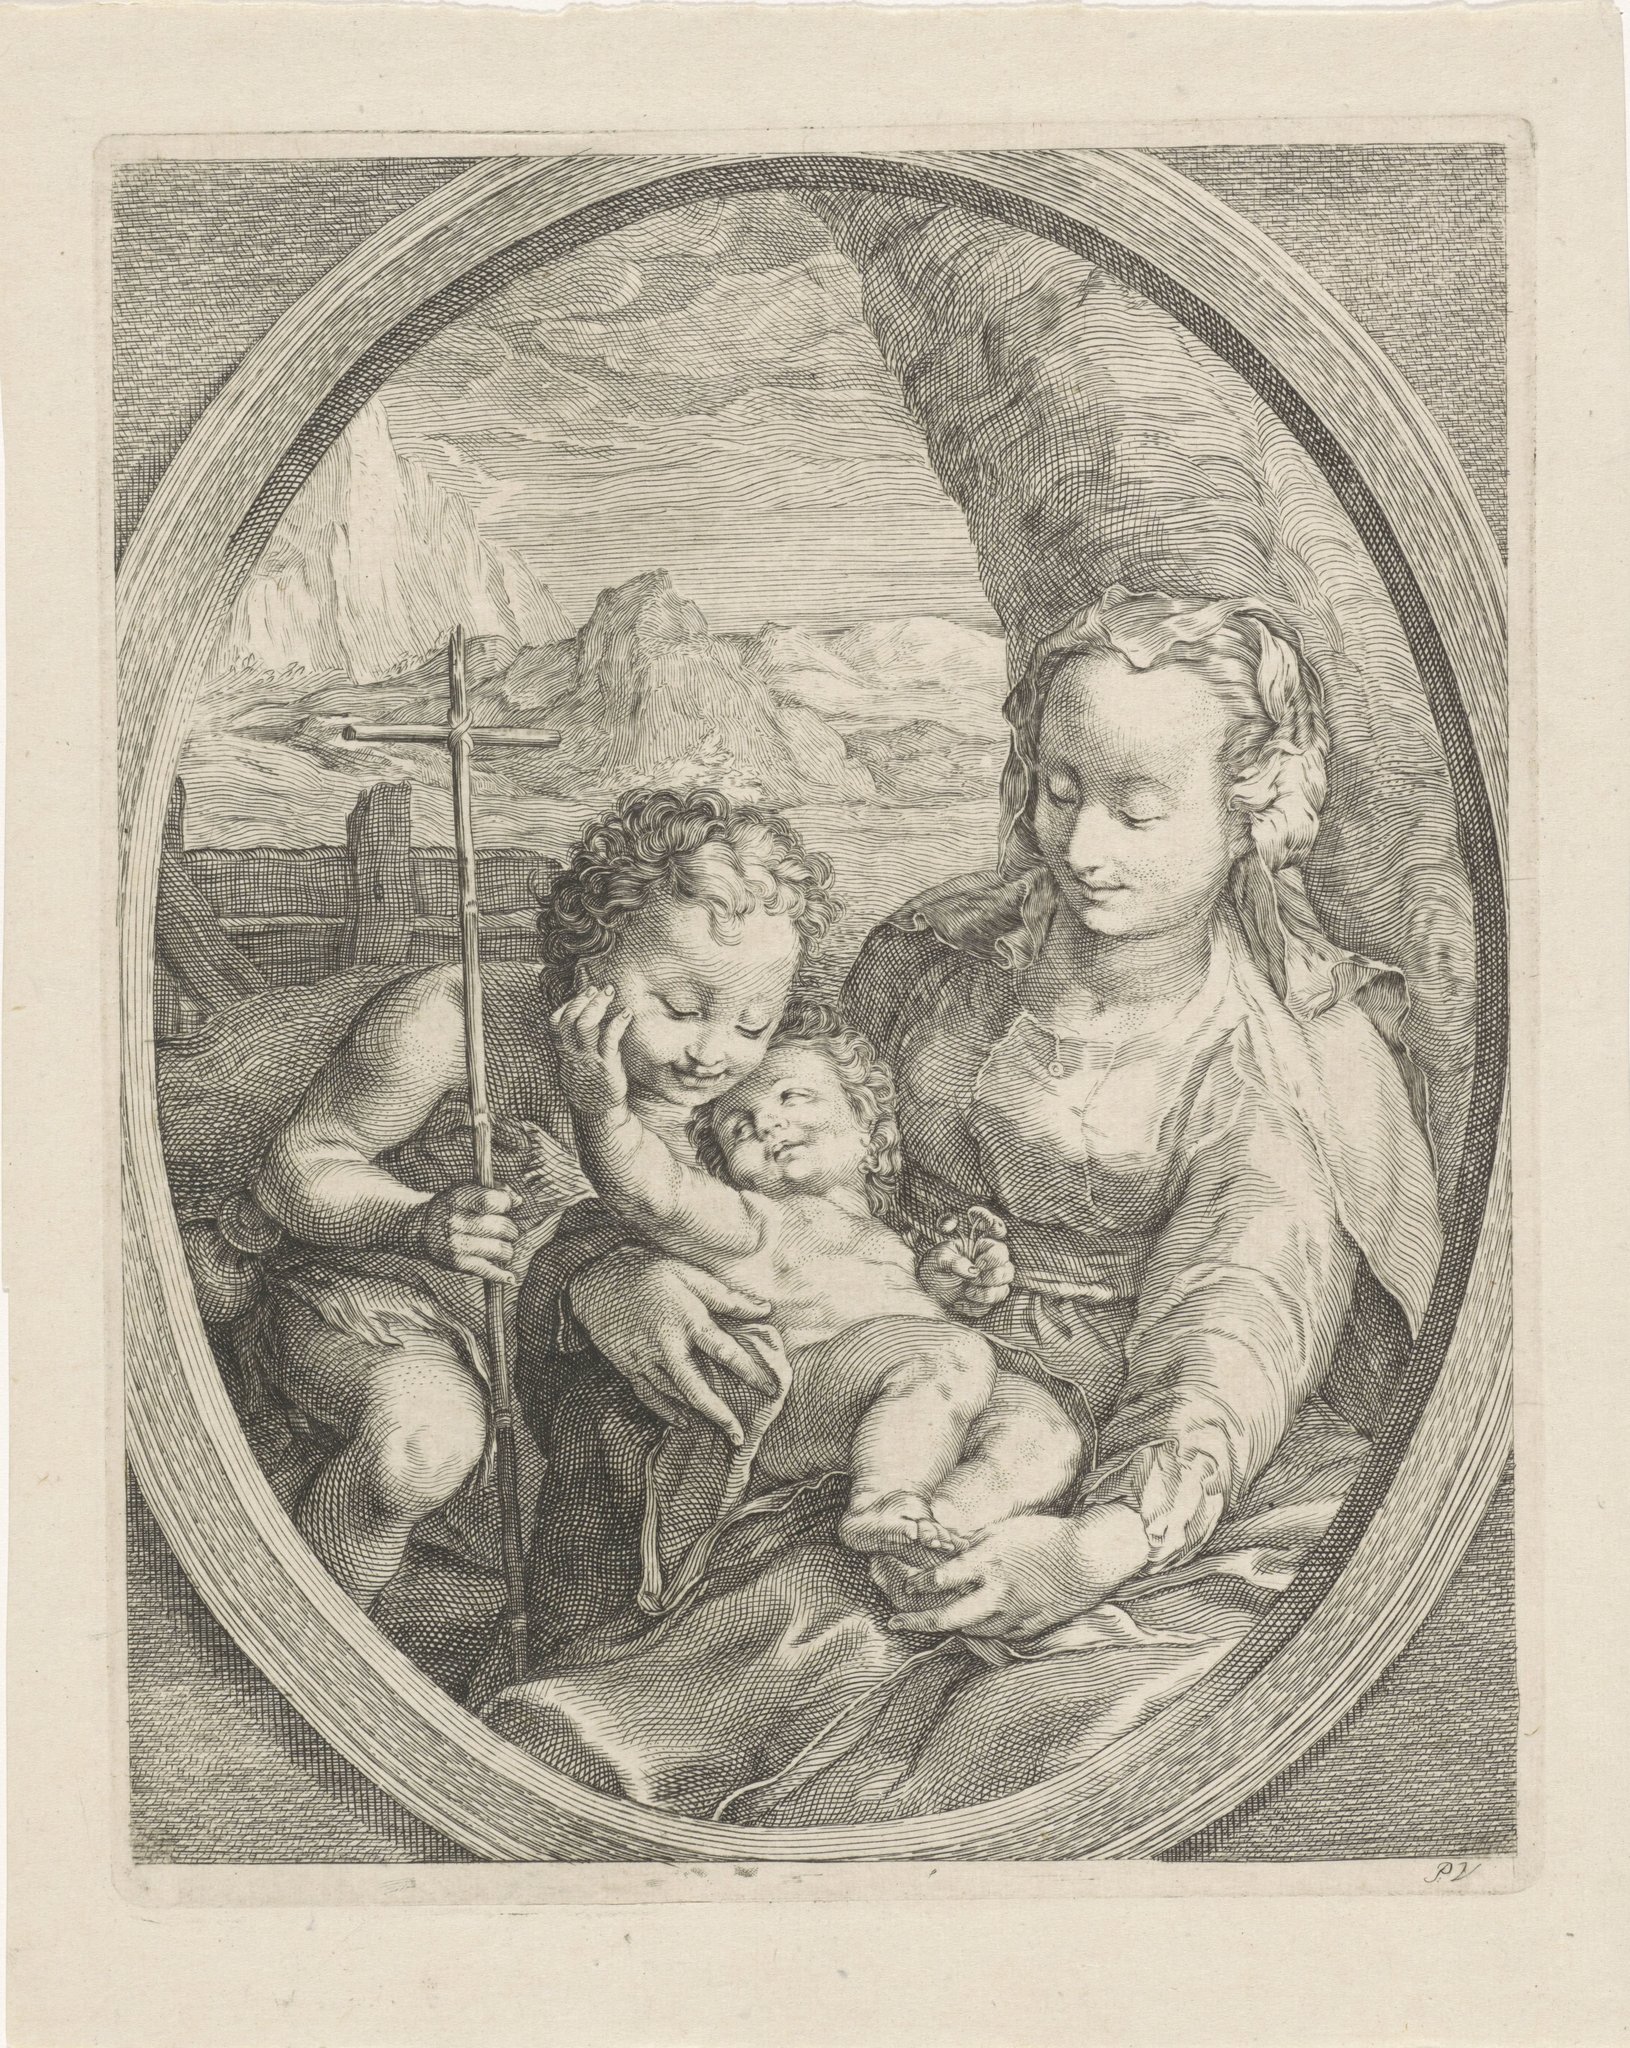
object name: print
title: Heilige Familie met Johannes de Doper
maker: monogrammist pv (graveur)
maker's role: print maker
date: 1550-1662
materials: paper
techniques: engraving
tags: holy family, and derived representations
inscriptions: collector's mark: Lugt 2228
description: Maria met het Christuskind op haar schoot. Daarbij zit de jonge Johannes de Doper met een kruis in zijn hand.